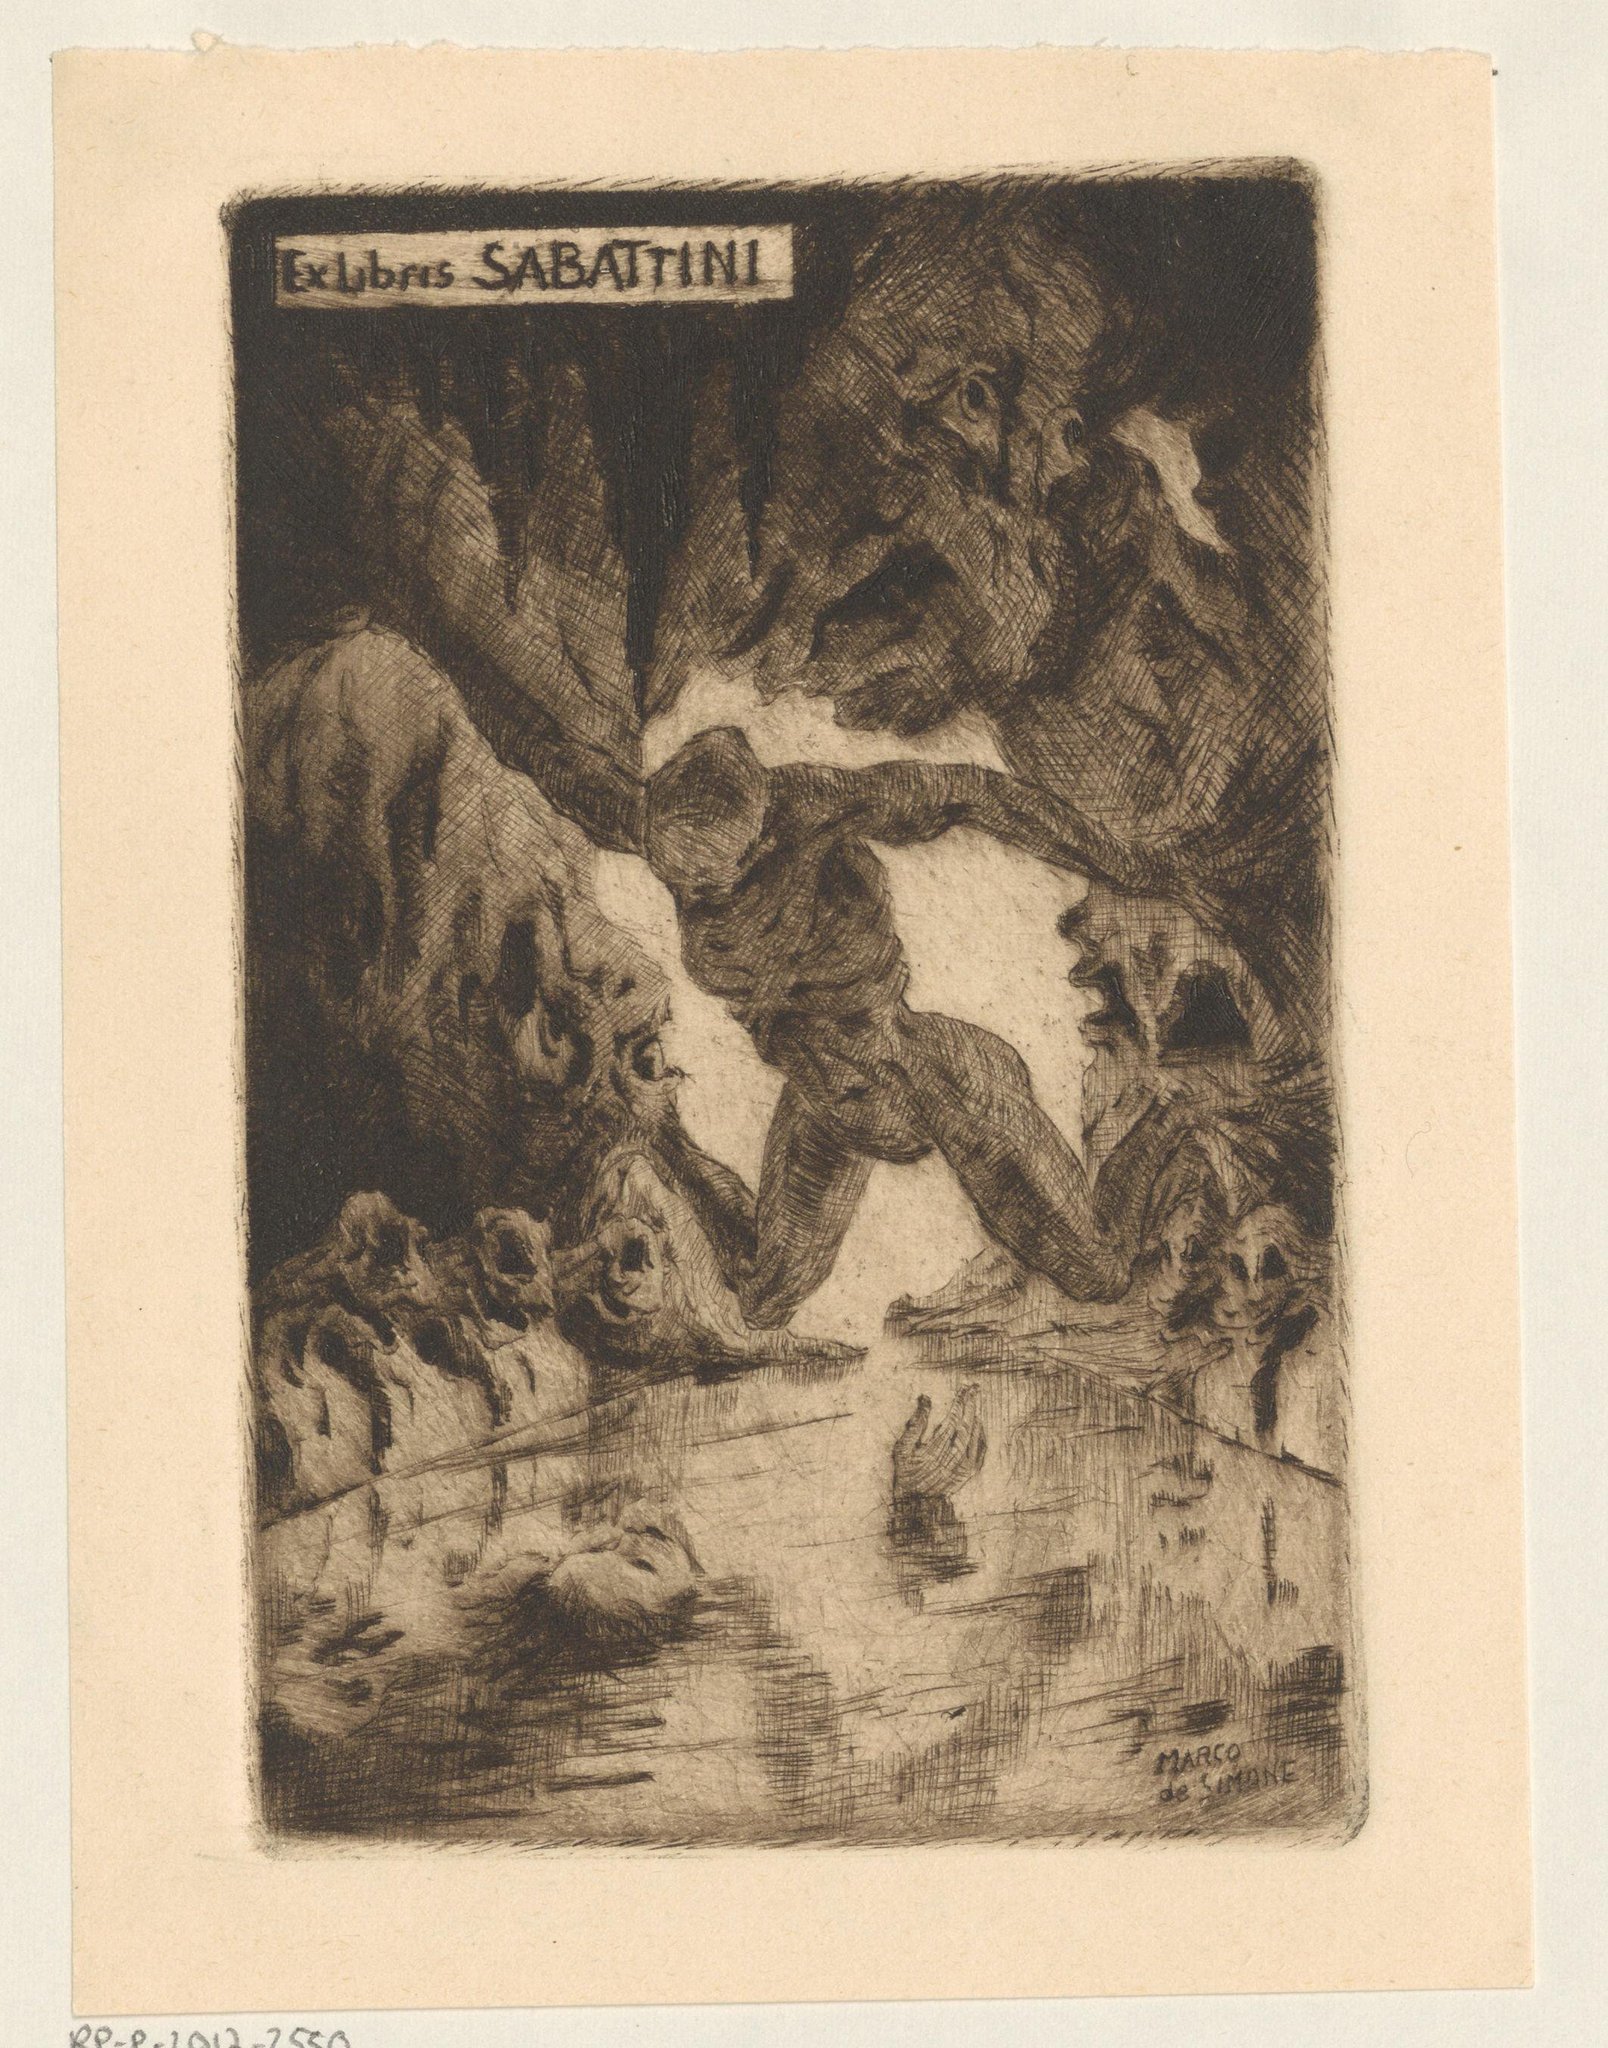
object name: bookplate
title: Ex libris van Gino Sabattini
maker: marco de simone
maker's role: print maker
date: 1949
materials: paper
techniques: drypoint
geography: italy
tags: gino sabattini, drowned person, cave, grotto, the corpse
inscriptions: inscription: ‘M. De Simone 1949’